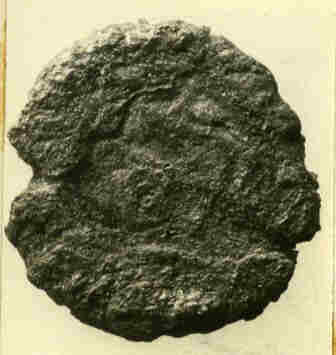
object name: coin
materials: copper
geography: iran